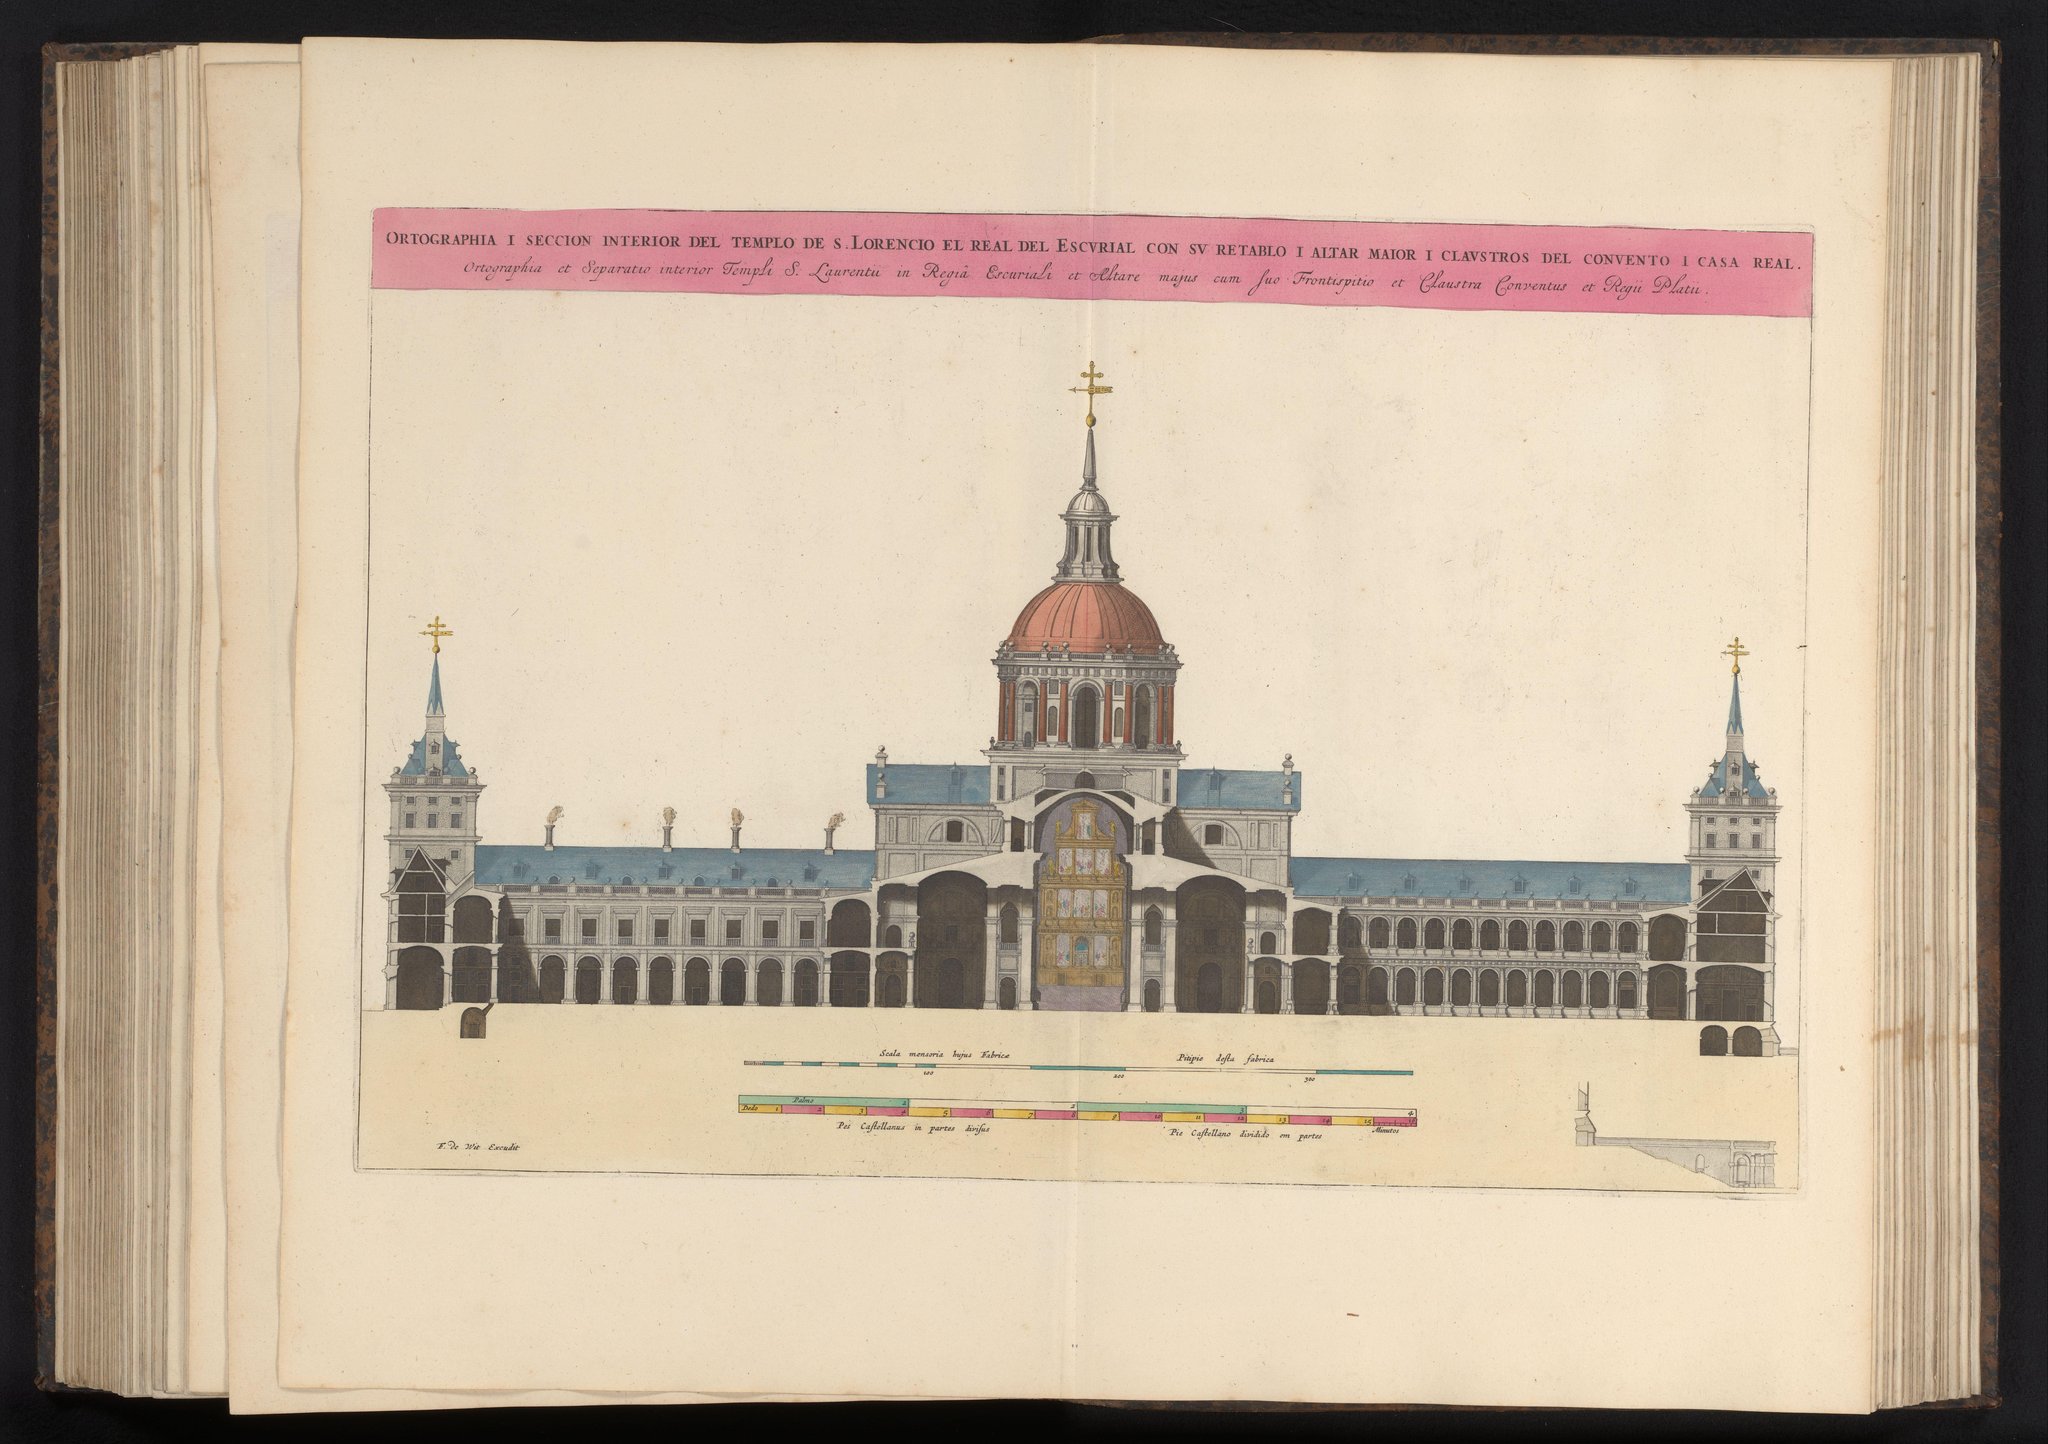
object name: album leaf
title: Opstand en doorsnede van de kerk van San Lorenzo met het altaarstuk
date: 1665-1706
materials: paper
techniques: engraving, hand coloring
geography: amsterdam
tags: exterior ~ representation of a building, series of designs, models, etc. of one architectural project, altar with altar-piece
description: Eerste staat gebruikt in: J. Blaeus Grooten Atlas, oft Werelt- Beschryving, in welcke 't Aerdryck, de Zee, en Hemel, wort vertoont en beschreven. Deel 8 getiteld: Achste stvck der Aerdrycks-Beschryving welck vervat Spaenjen, Africa en America, Amsterdam: Johannes Willemszoon Blaeu, 1665.